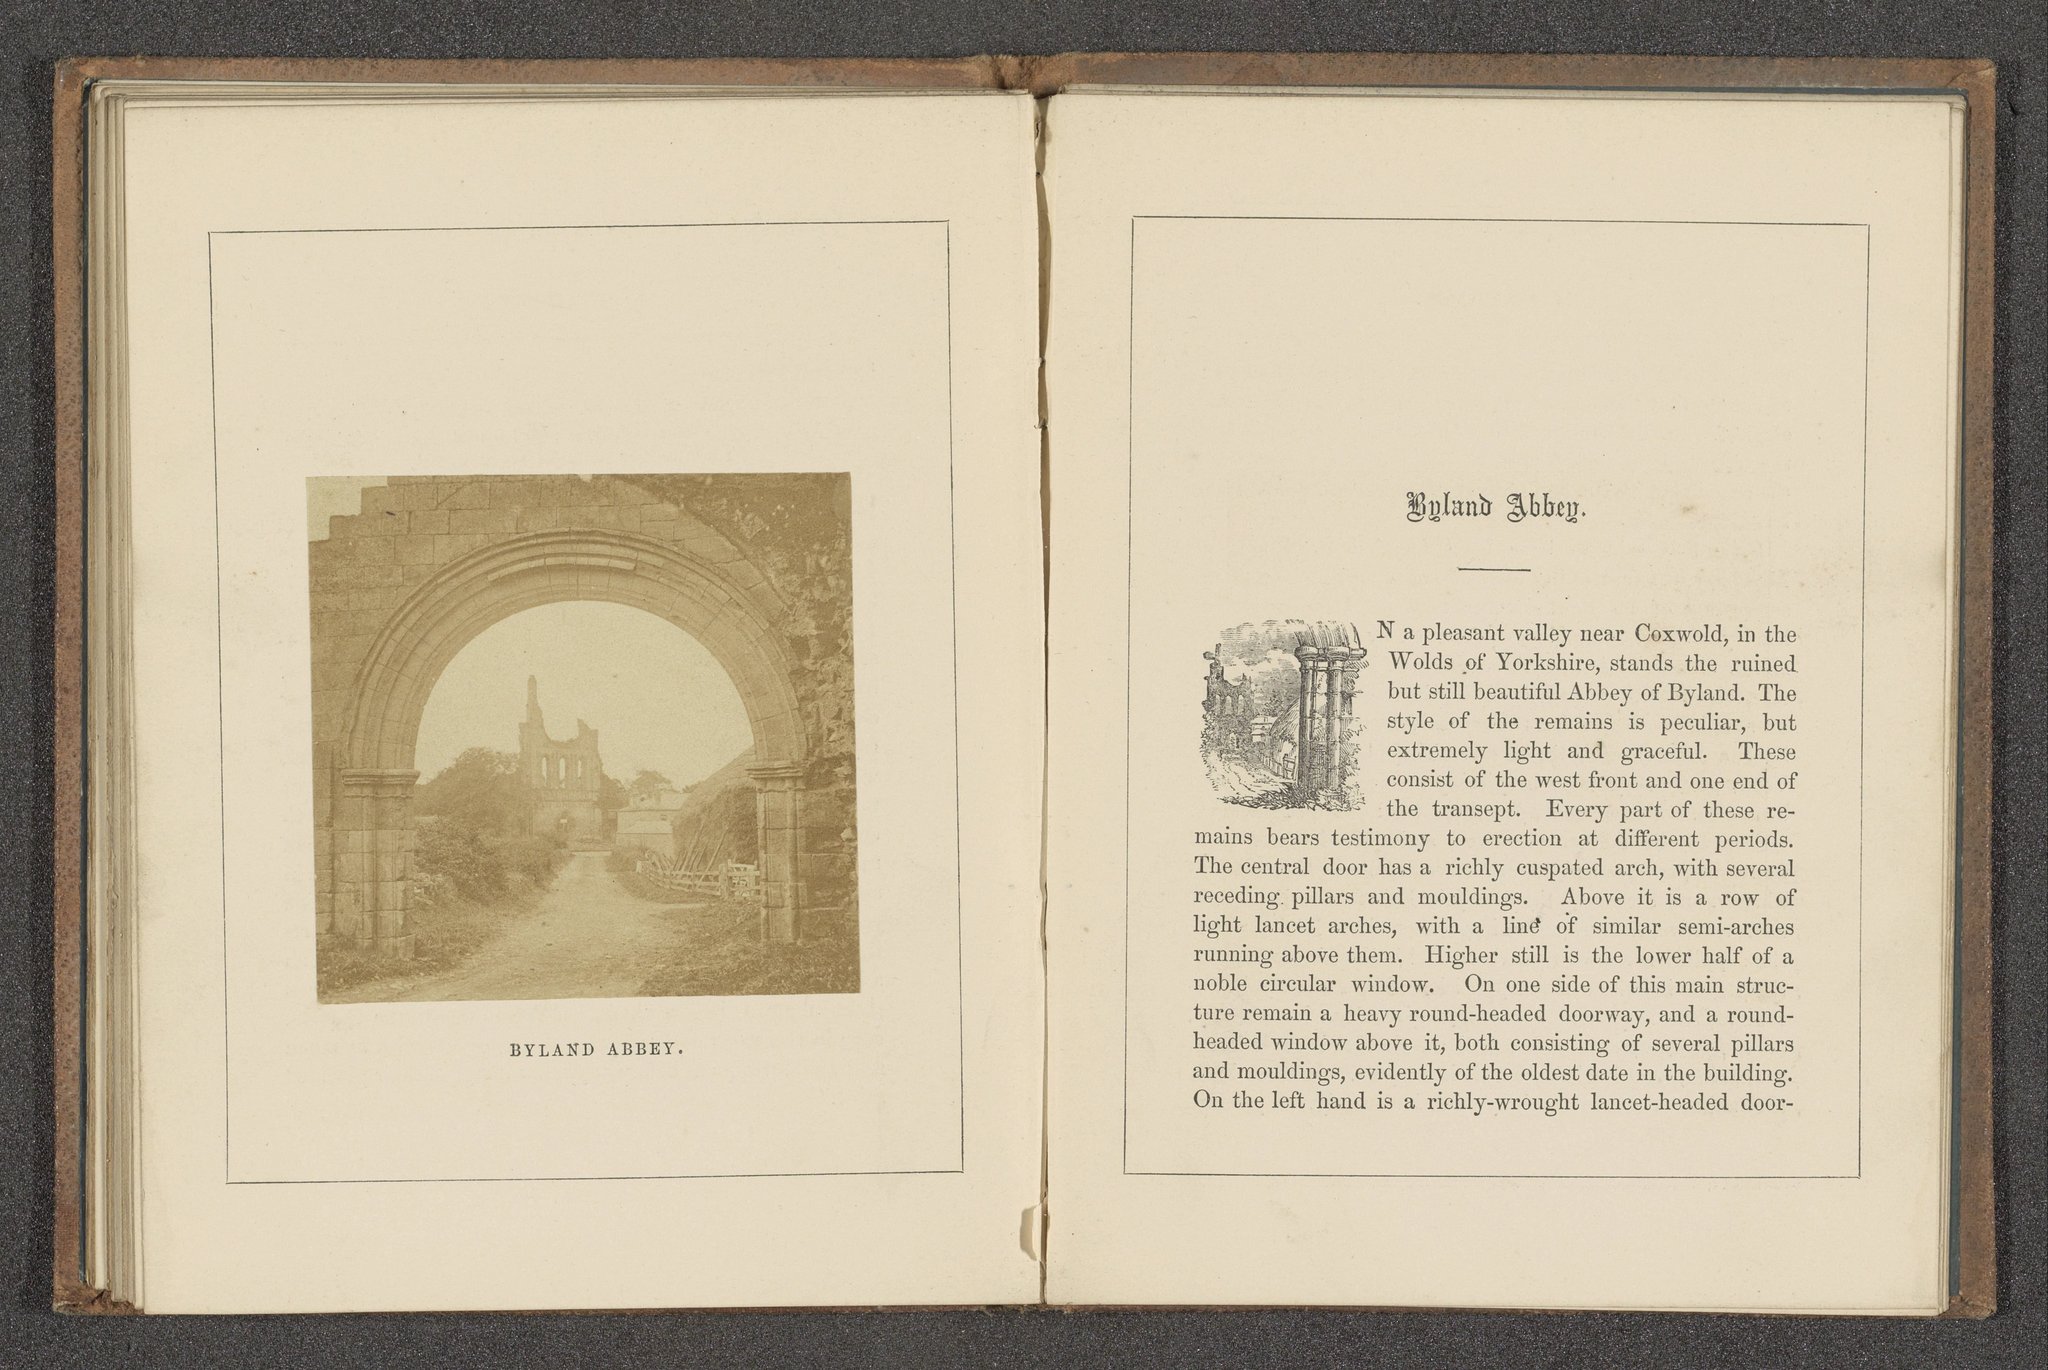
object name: page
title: Gezicht op de ruïne van Byland Abbey door een poort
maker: thomas ogle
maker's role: fotograaf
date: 1855-1865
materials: photographic support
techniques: albumen print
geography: byland abbey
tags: gate, entrance, ruin of church, monastery, etc.